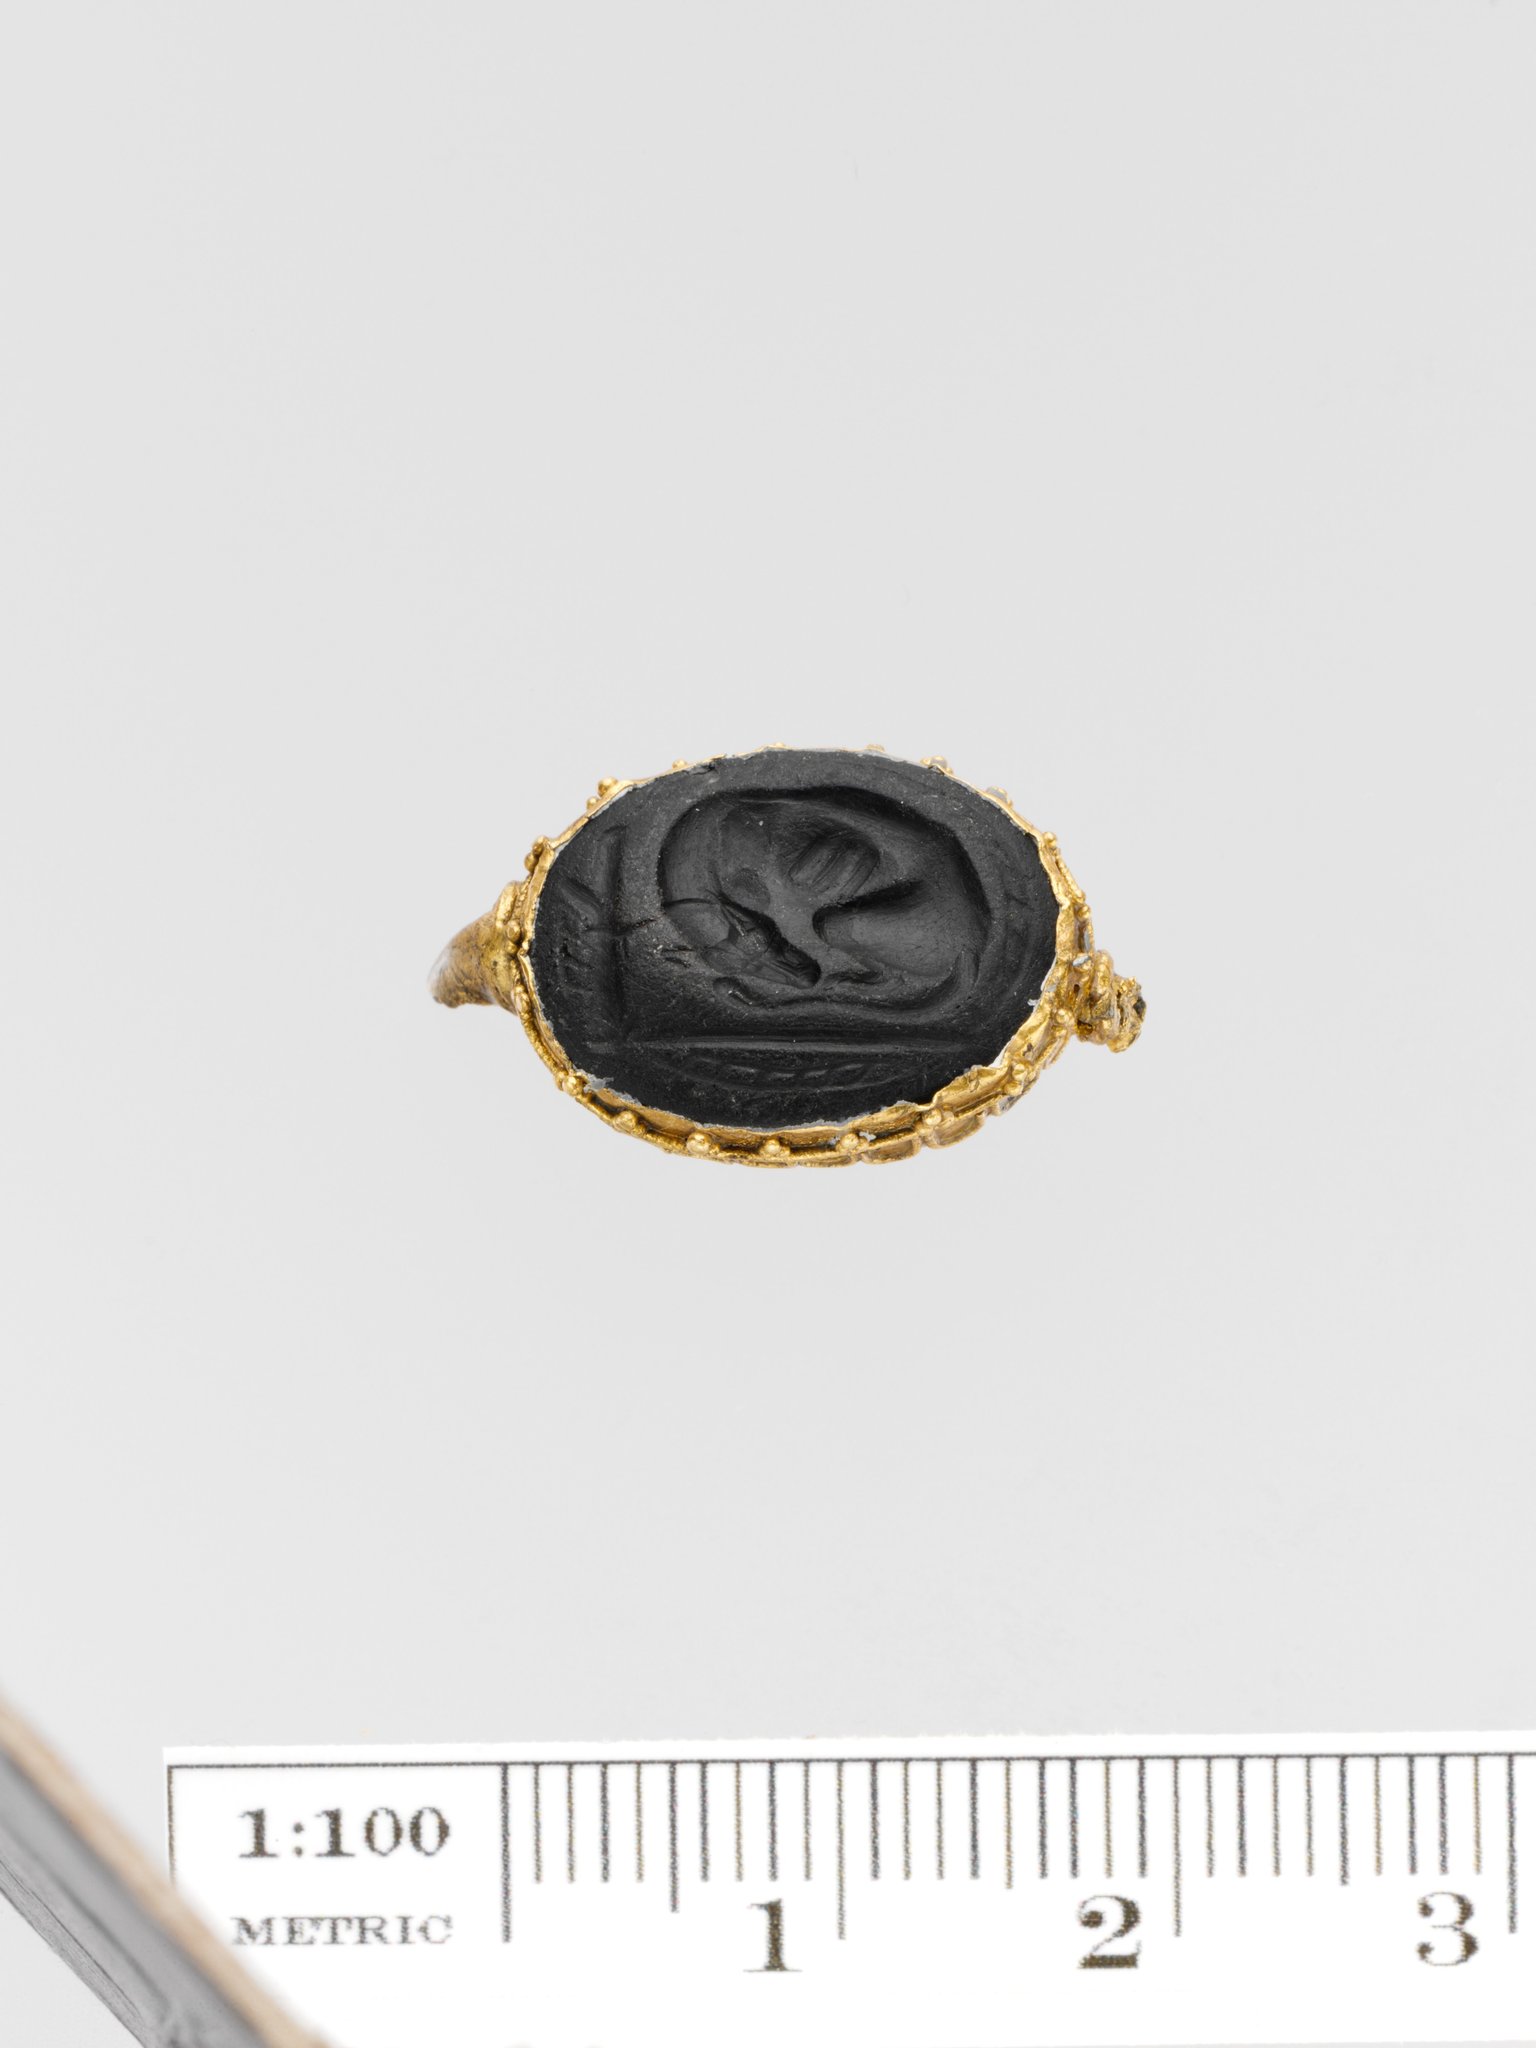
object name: ring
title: Obsidian seal set in a gold ring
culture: greek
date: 450-400 BCE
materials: bronze, gold, jasper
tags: dogs